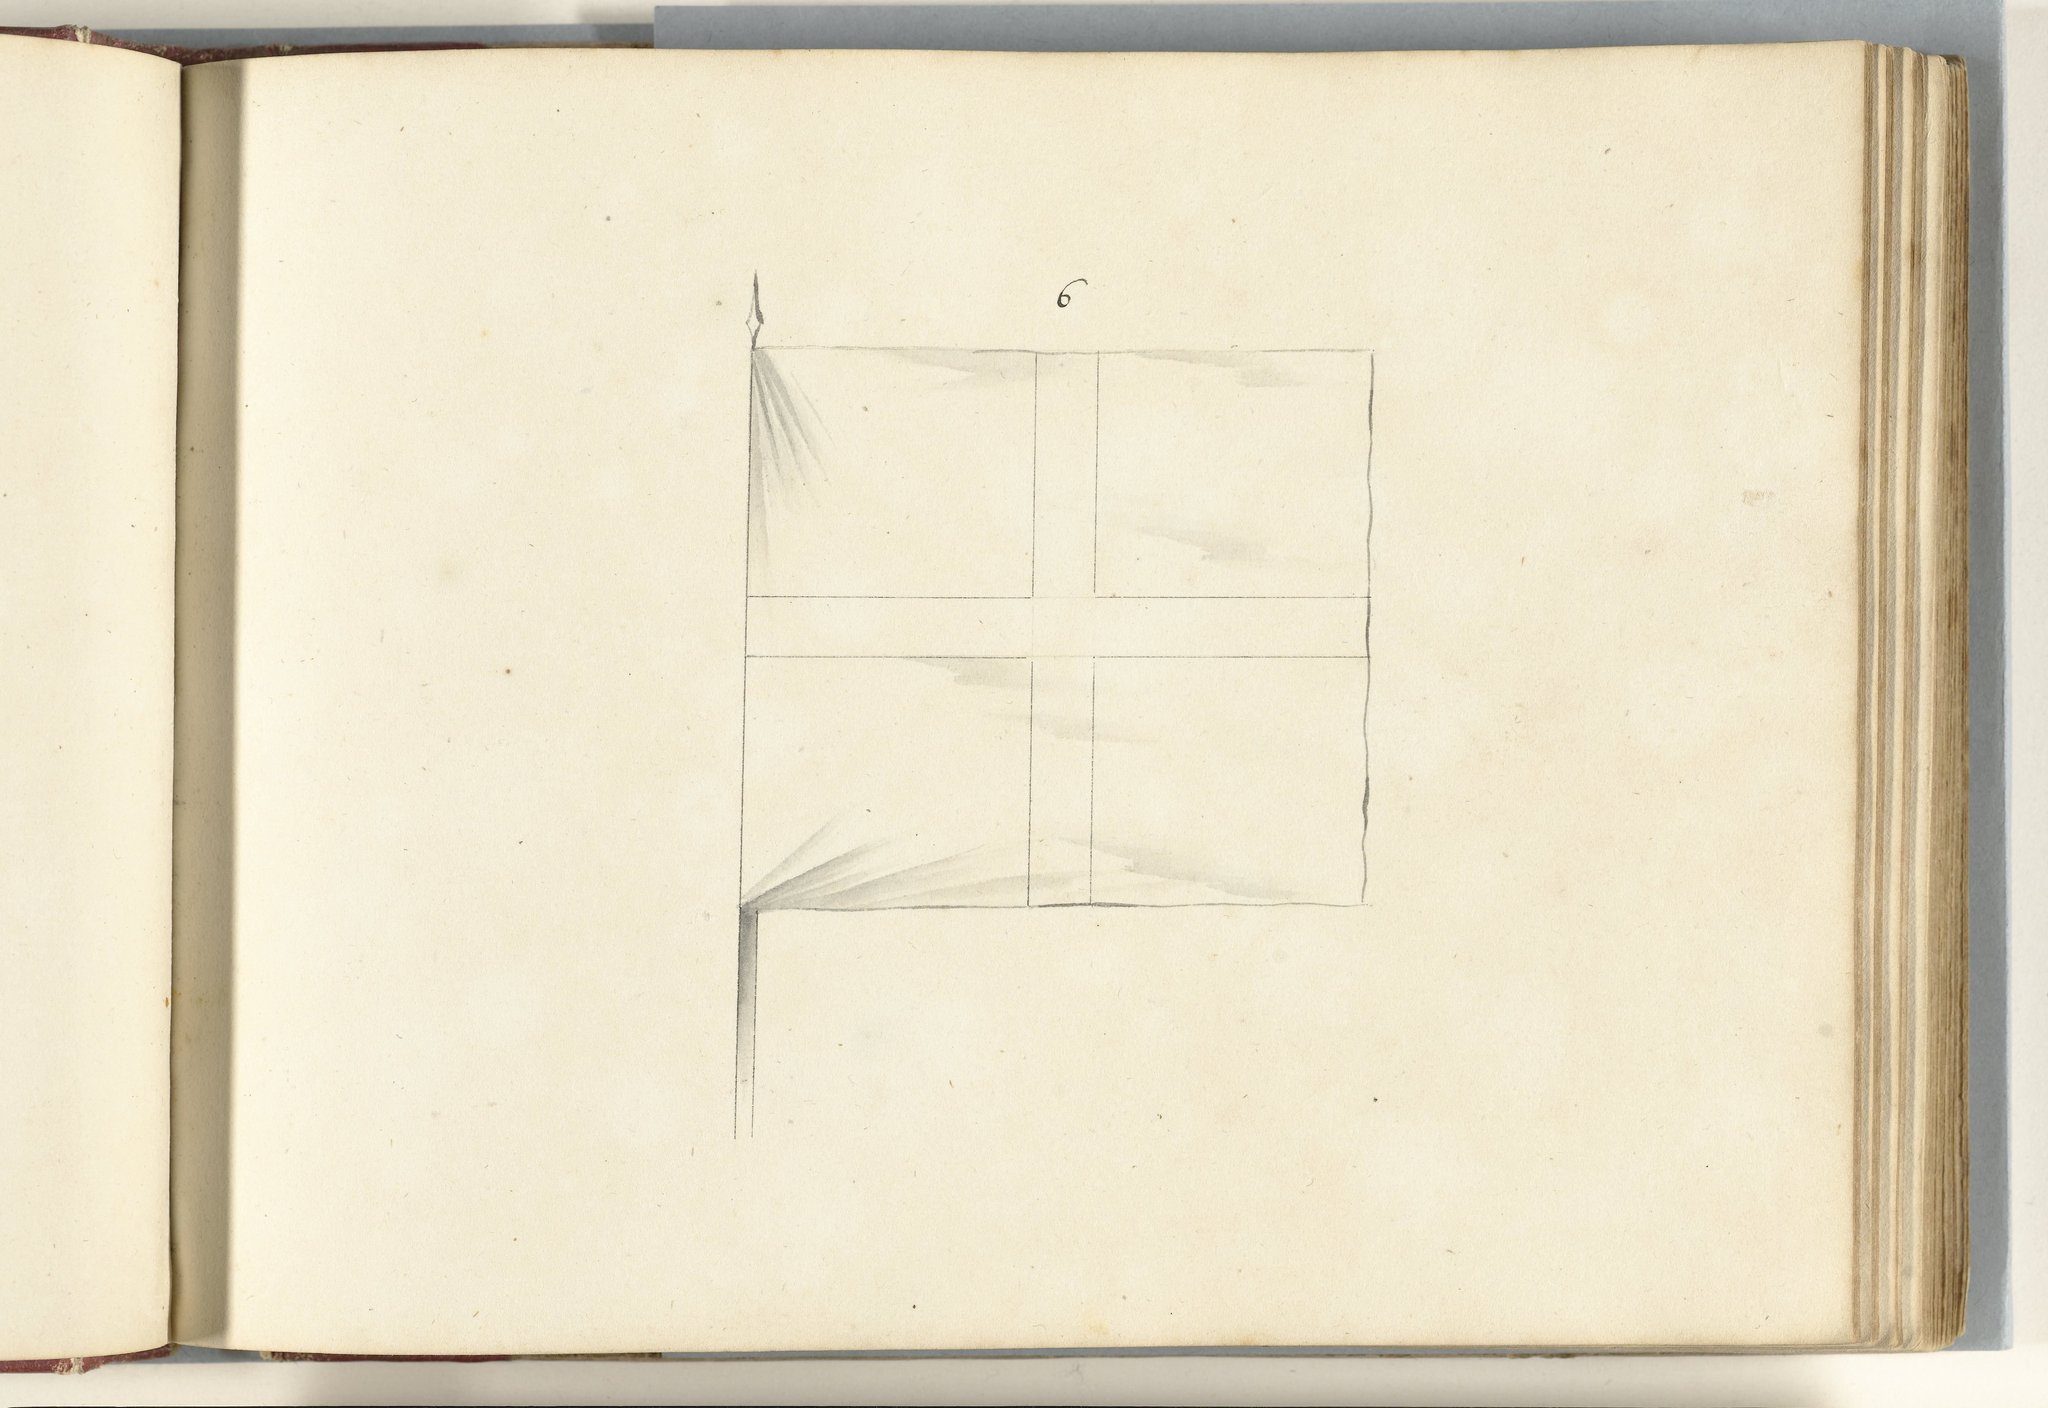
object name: drawing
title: Frans vaandel veroverd bij de slag bij Ramillies, 1706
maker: Anonymous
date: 1713-1720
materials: paper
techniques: drawing, writing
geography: northern netherlands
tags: (military) flags and standards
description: Frans vaandel veroverd bij de slag bij Ramillies 1706. In het boek met tekeningen van Franse vaandels, standaarden en pauken, veroverd tijdens de Spaanse Successieoorlog (1701-1713).